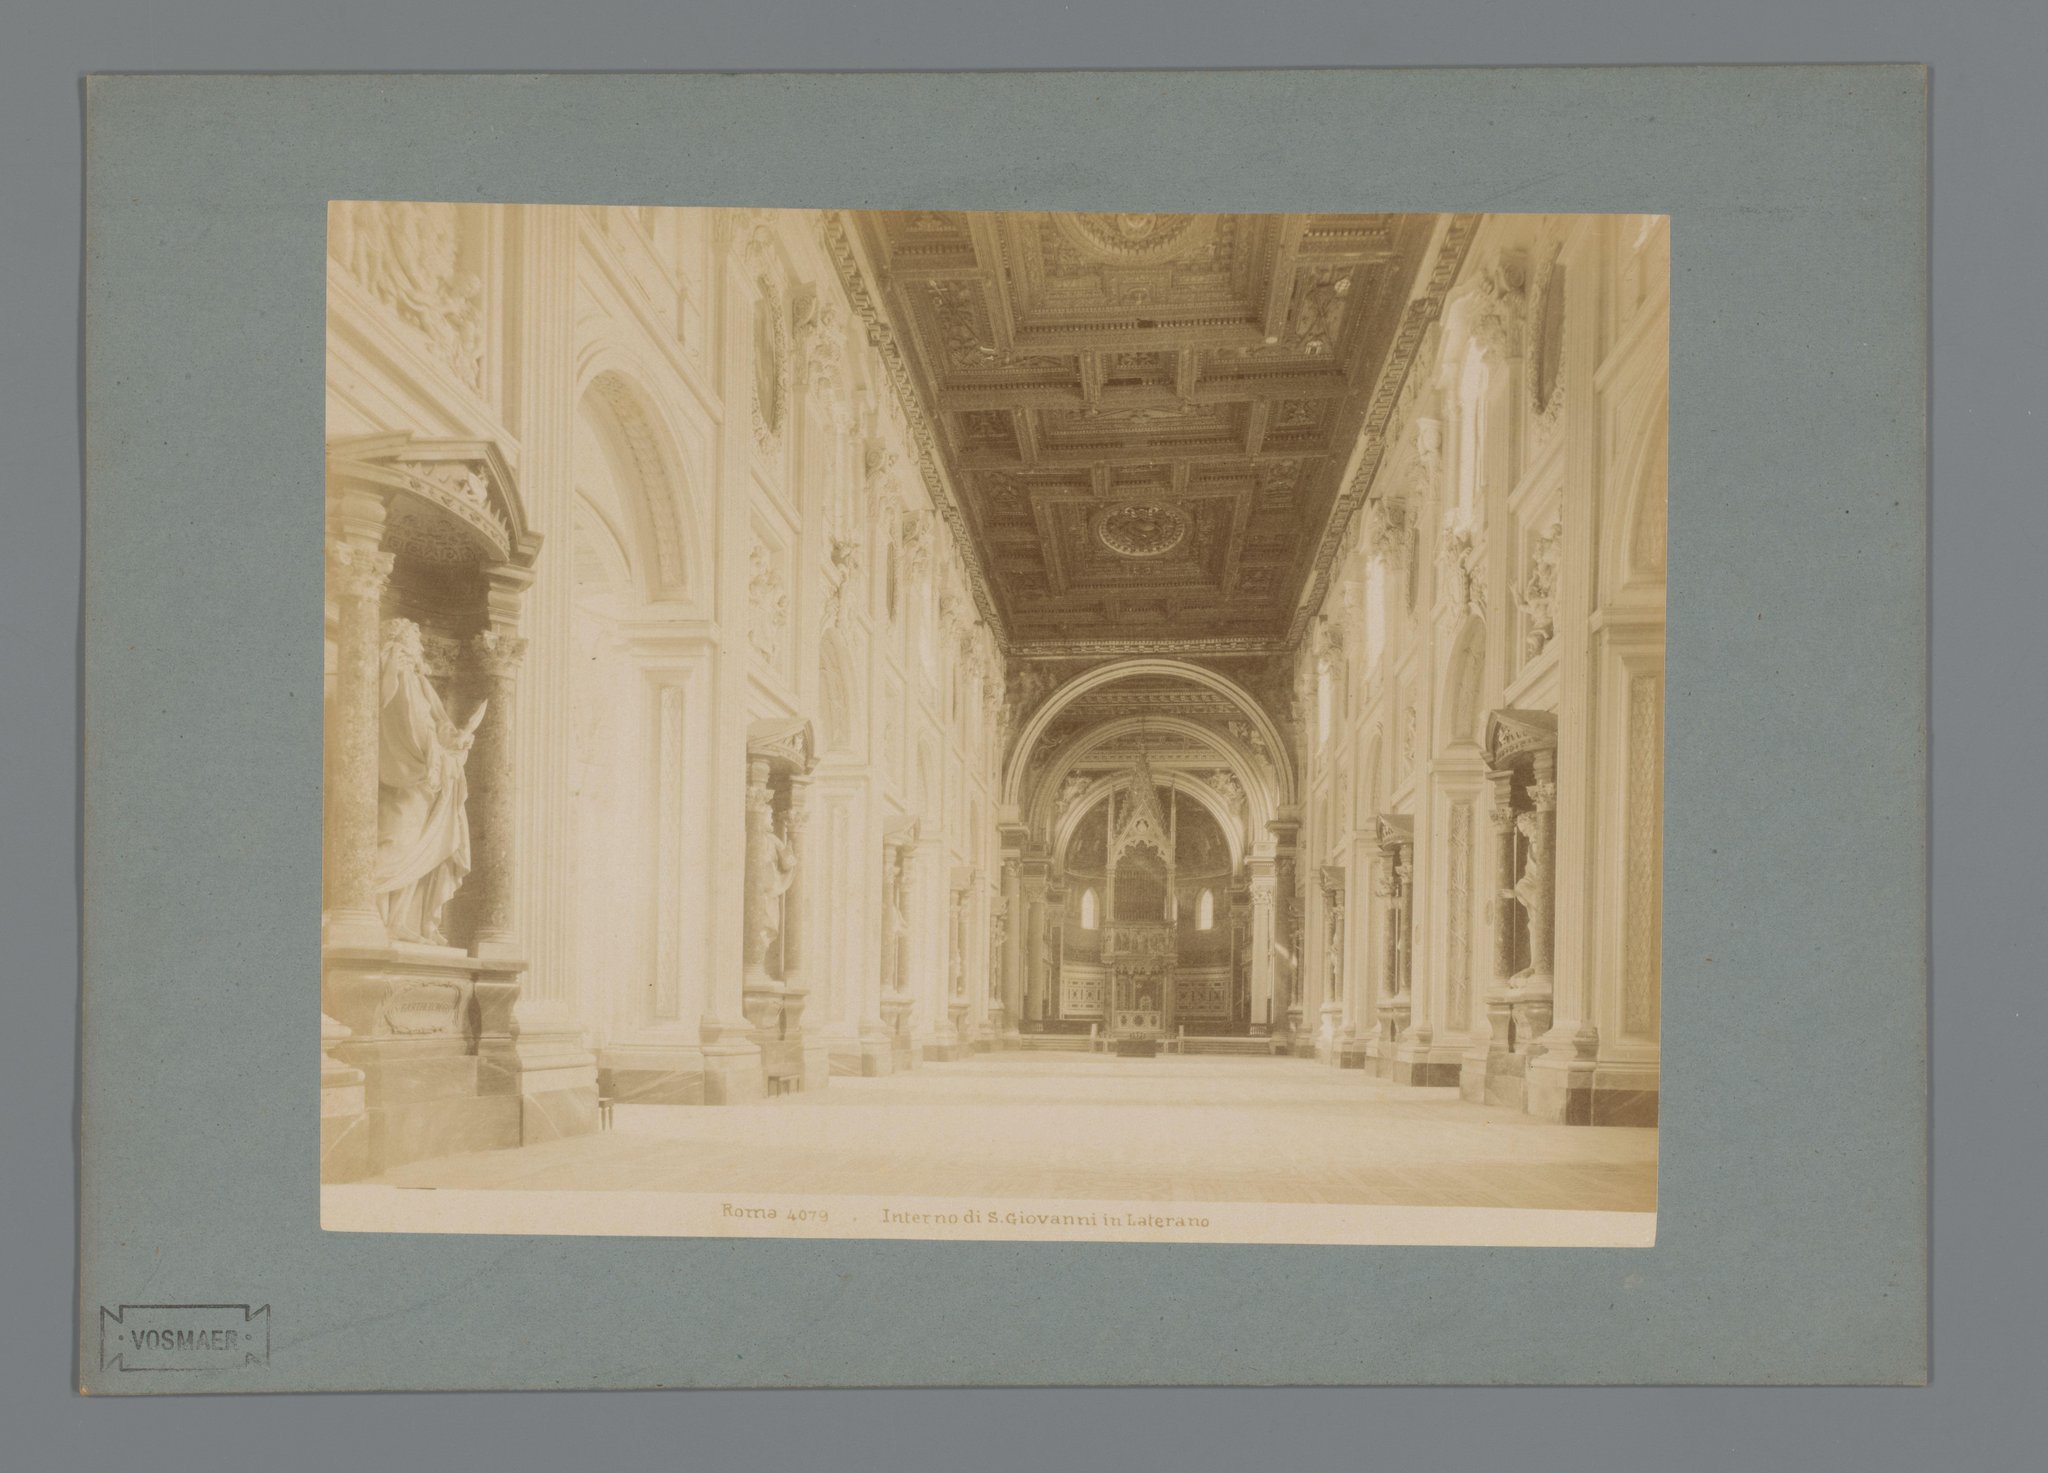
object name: photograph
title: Roma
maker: Anonymous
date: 1851-1890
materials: cardboard, paper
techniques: albumen print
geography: rome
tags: interior of church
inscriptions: number: ‘4079’, collector's mark: ‘VOSMAER’